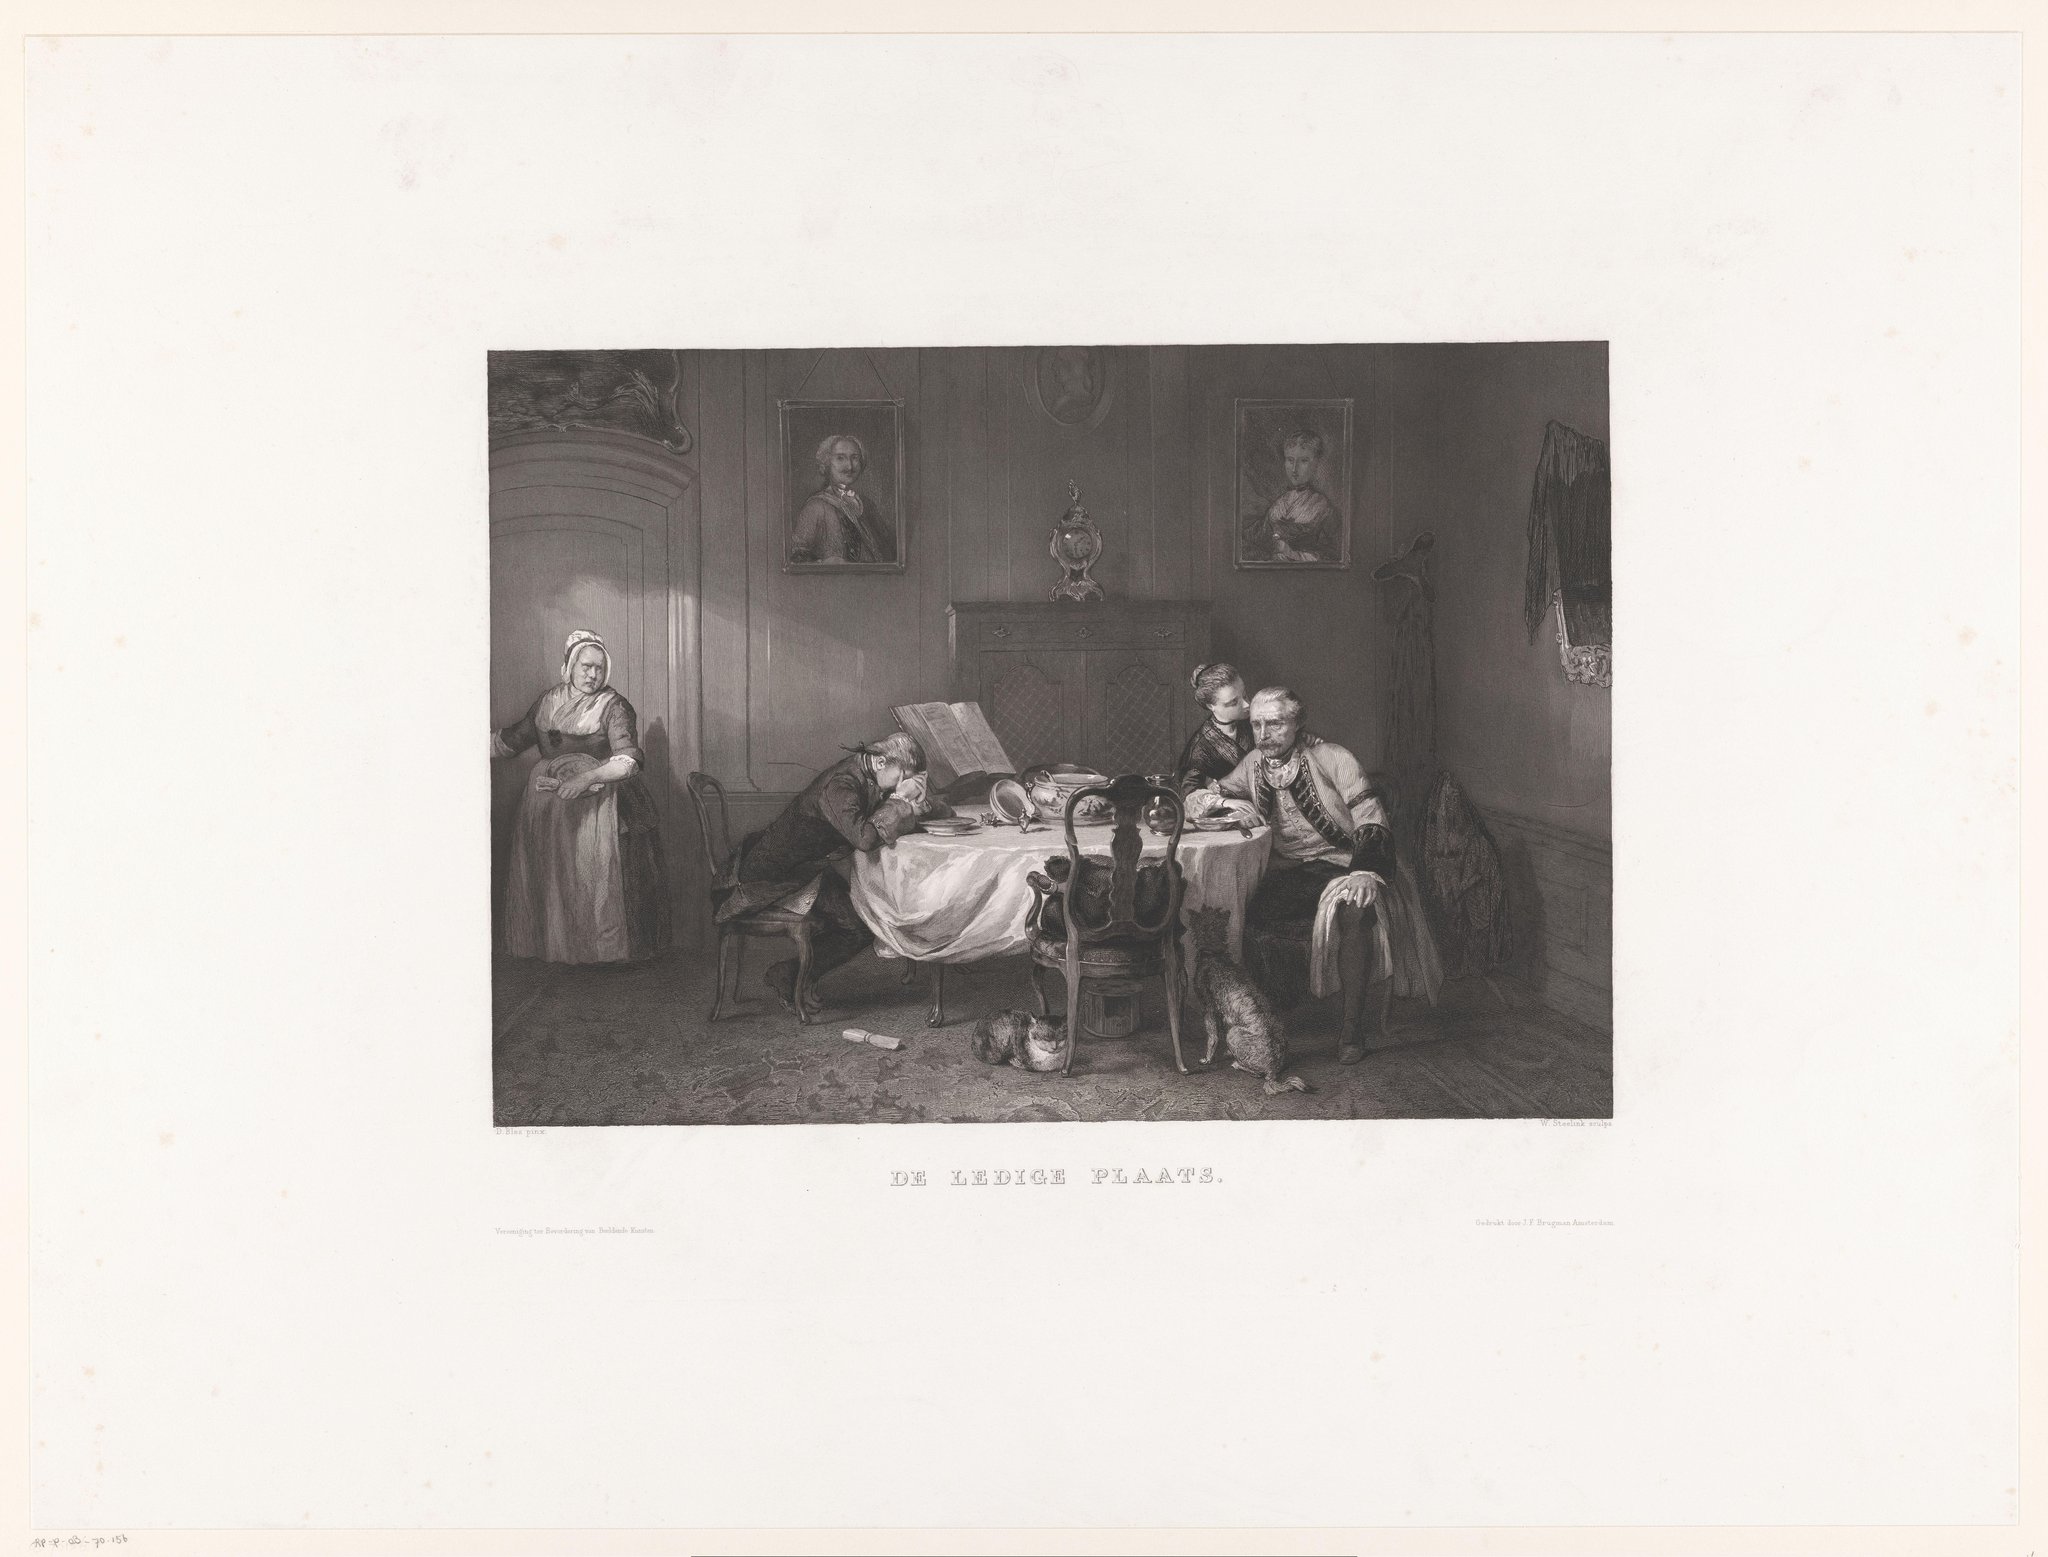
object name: print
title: De lege stoel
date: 1869-1913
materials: paper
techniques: engraving, etching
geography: amsterdam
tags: mourning customs, family life, (family) meal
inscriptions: collector's mark: Lugt 2228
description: In een interieur zit een gezin aan tafel, terwijl de stoel van moeder en vrouw leeg is. De jongen verbergt zijn gezicht in zijn handen. De heer des huizes kijkt naar de lege stoel, terwijl zijn dochter hem troost. Bij de stoel een hond en een kat. Links bij de deur de meid die droevig het gezin beschouwt.